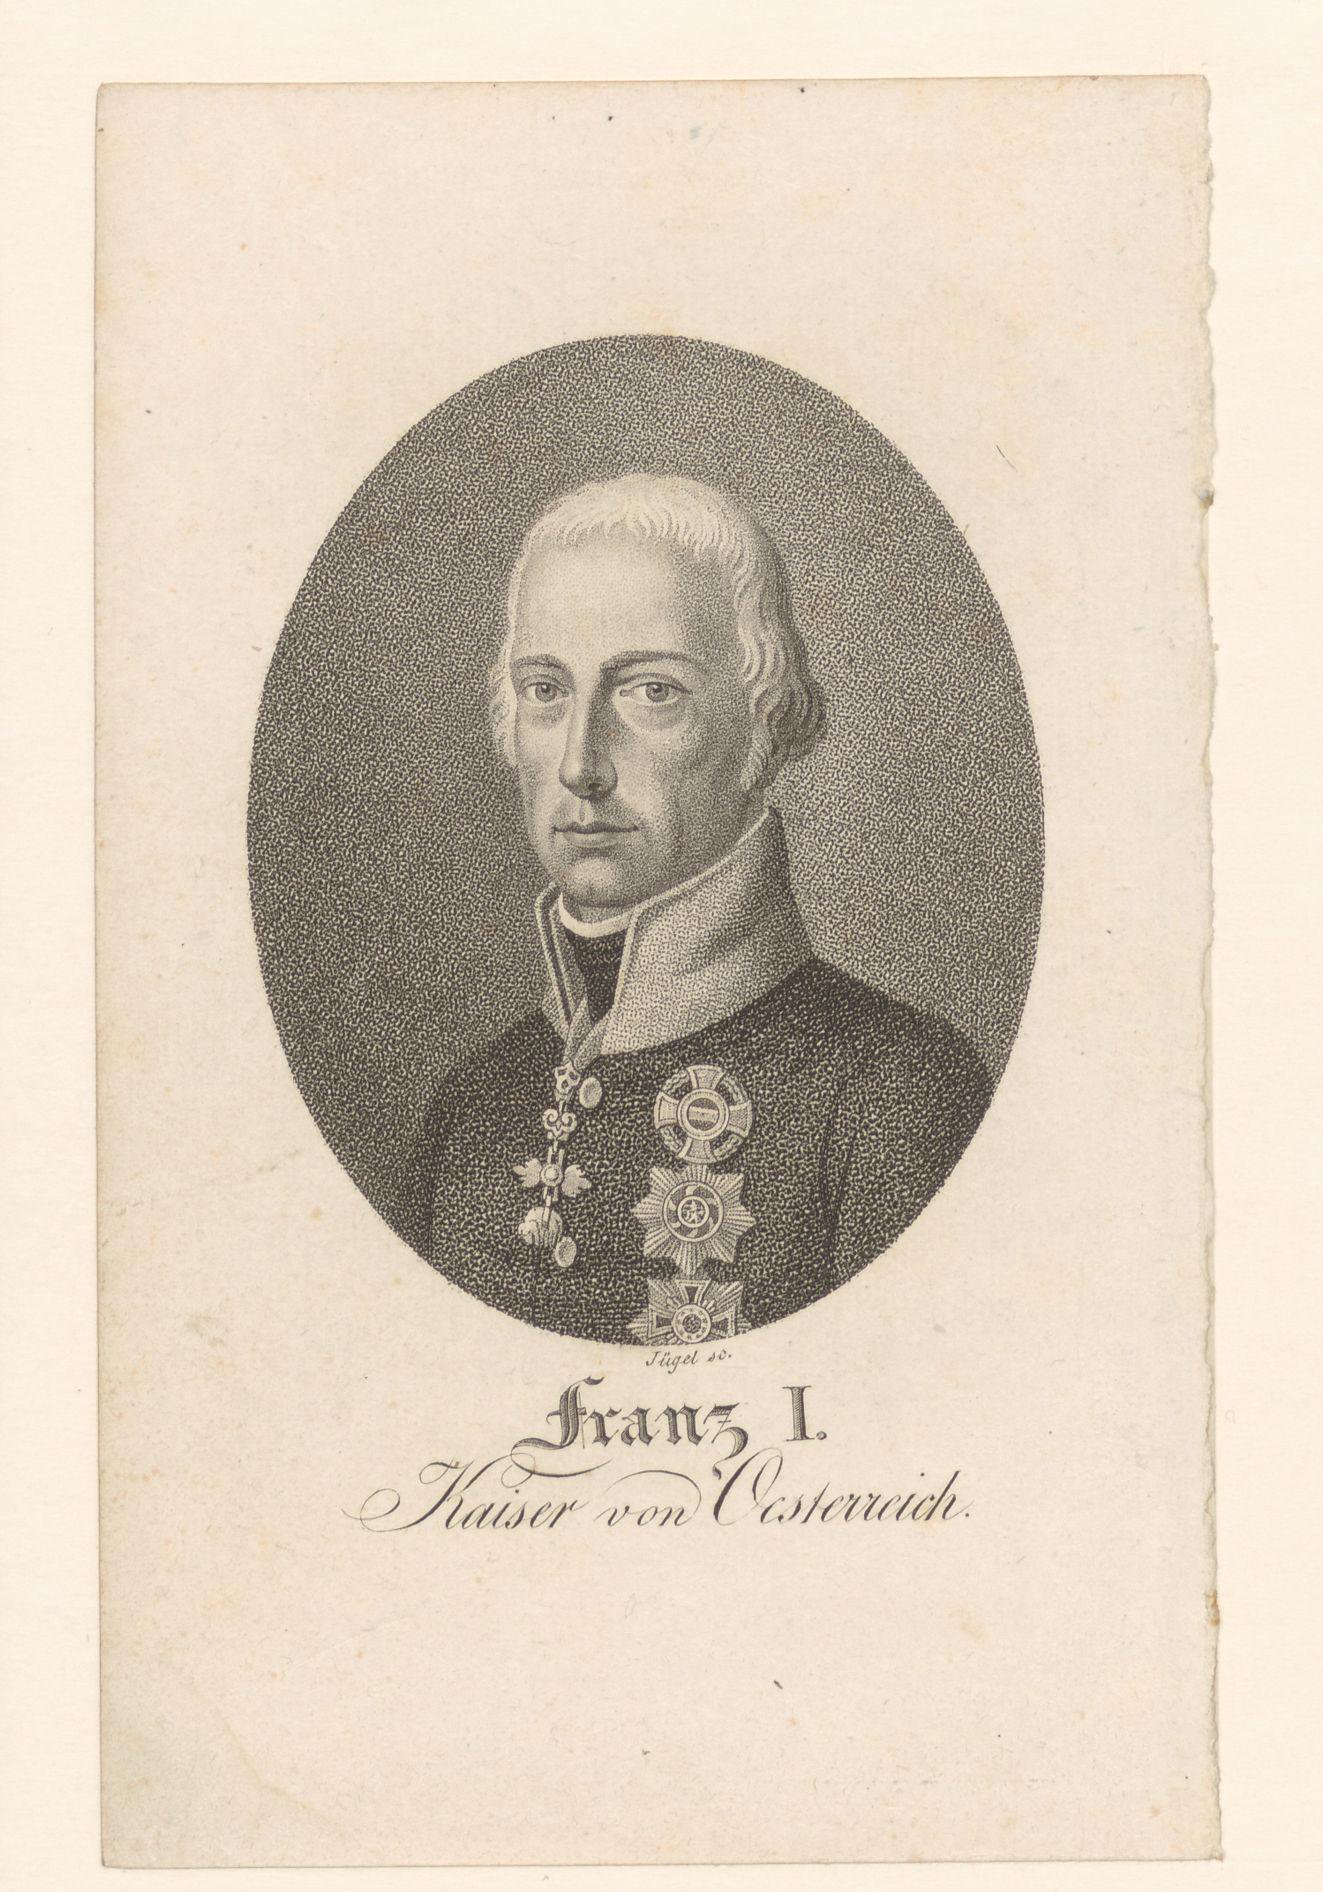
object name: print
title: Portret van Frans II Josef Karel, Rooms-Duits keizer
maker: friedrich jügel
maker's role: print maker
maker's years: 1772-1833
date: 1782-1833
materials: paper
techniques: stippling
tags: vienna, frans ii (rooms-duits keizer), knighthood order: teutonic order - insignia of a knighthood order, e.g.: badge, chain (with name of order), historical persons, medals and other marks of military honour, ruler, sovereign, knighthood order of the golden fleece - insignia of a knighthood order, e.g.: badge, chain (with name of order)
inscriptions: collector's mark: Lugt 2228